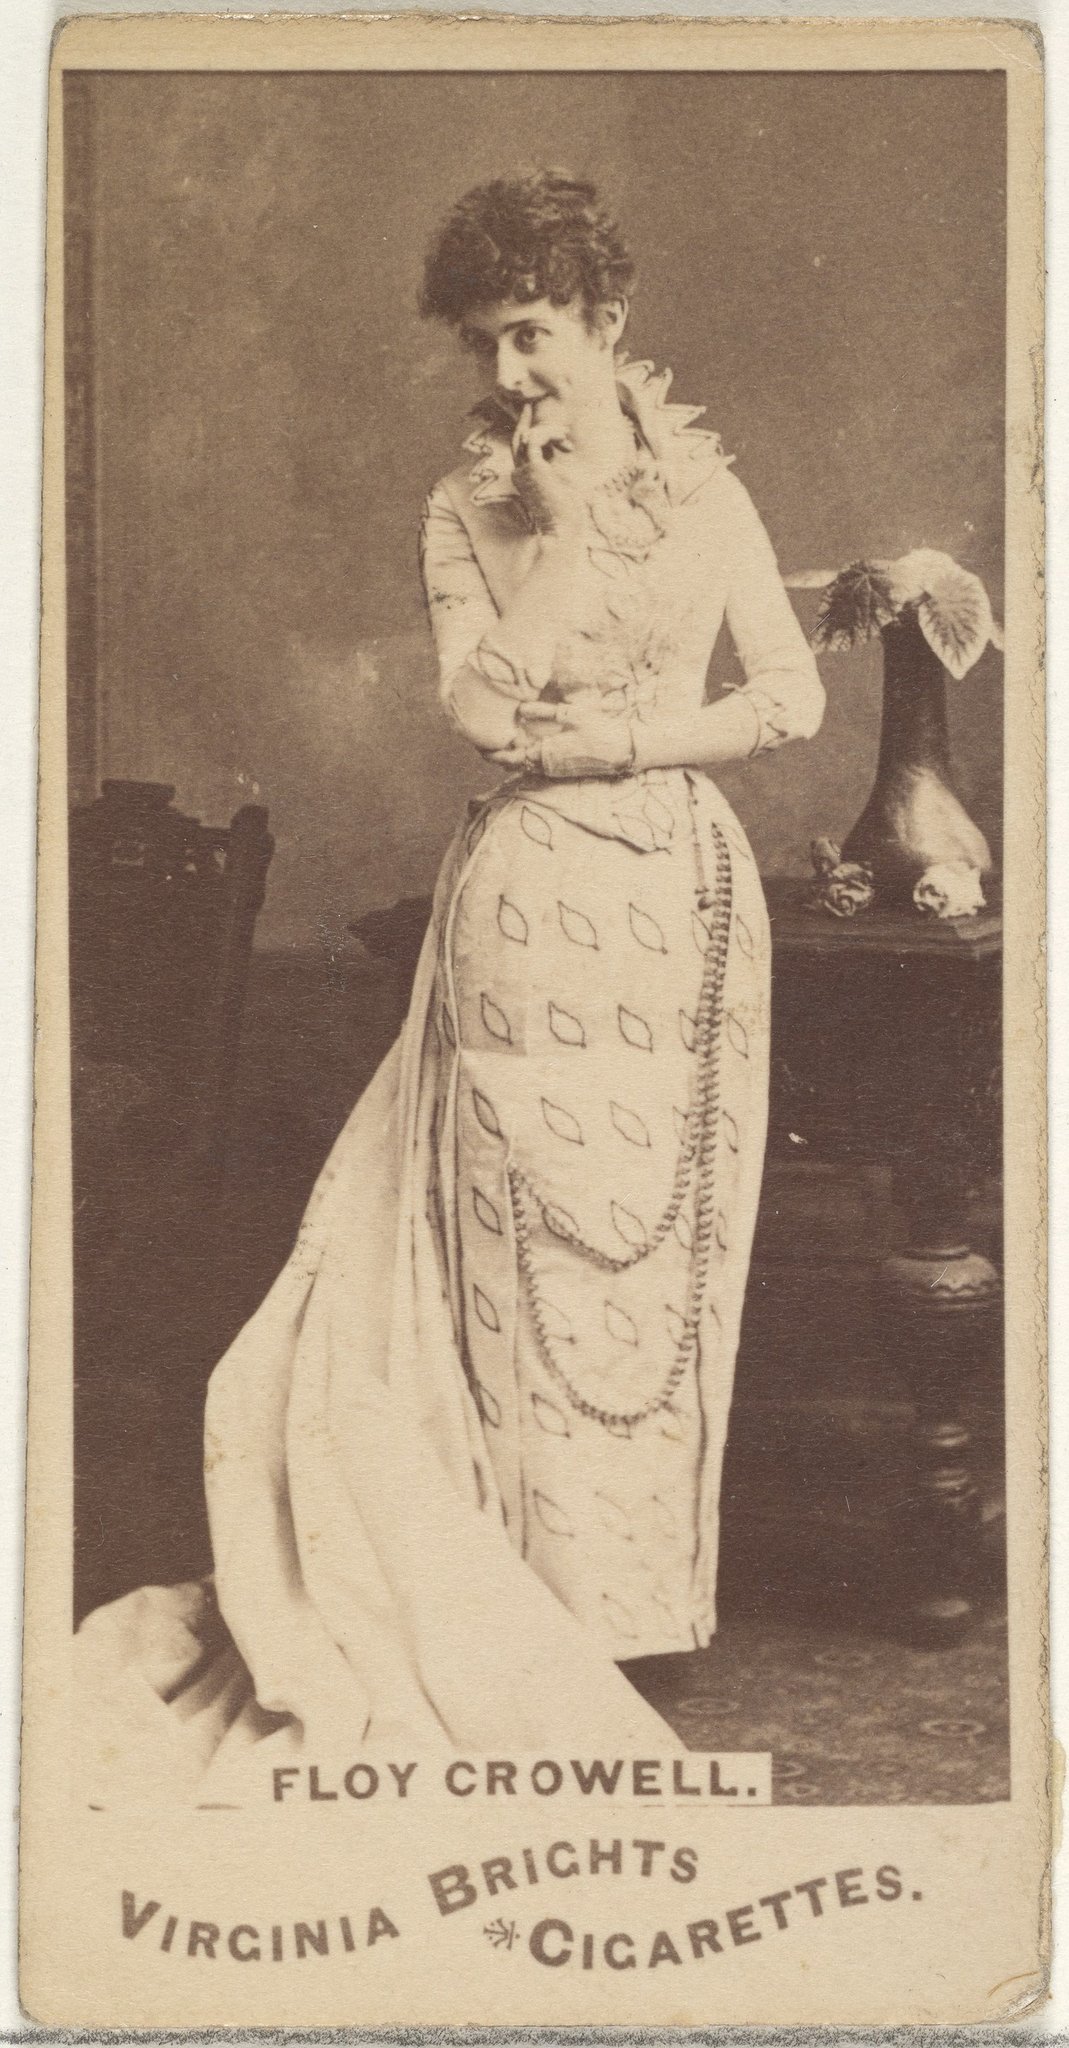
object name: photograph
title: Floy Crowell, from the Actors and Actresses series (N45, Type 1) for Virginia Brights Cigarettes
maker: allen & ginter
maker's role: publisher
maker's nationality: american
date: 1888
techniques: albumen silver print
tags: portraits,women,actresses